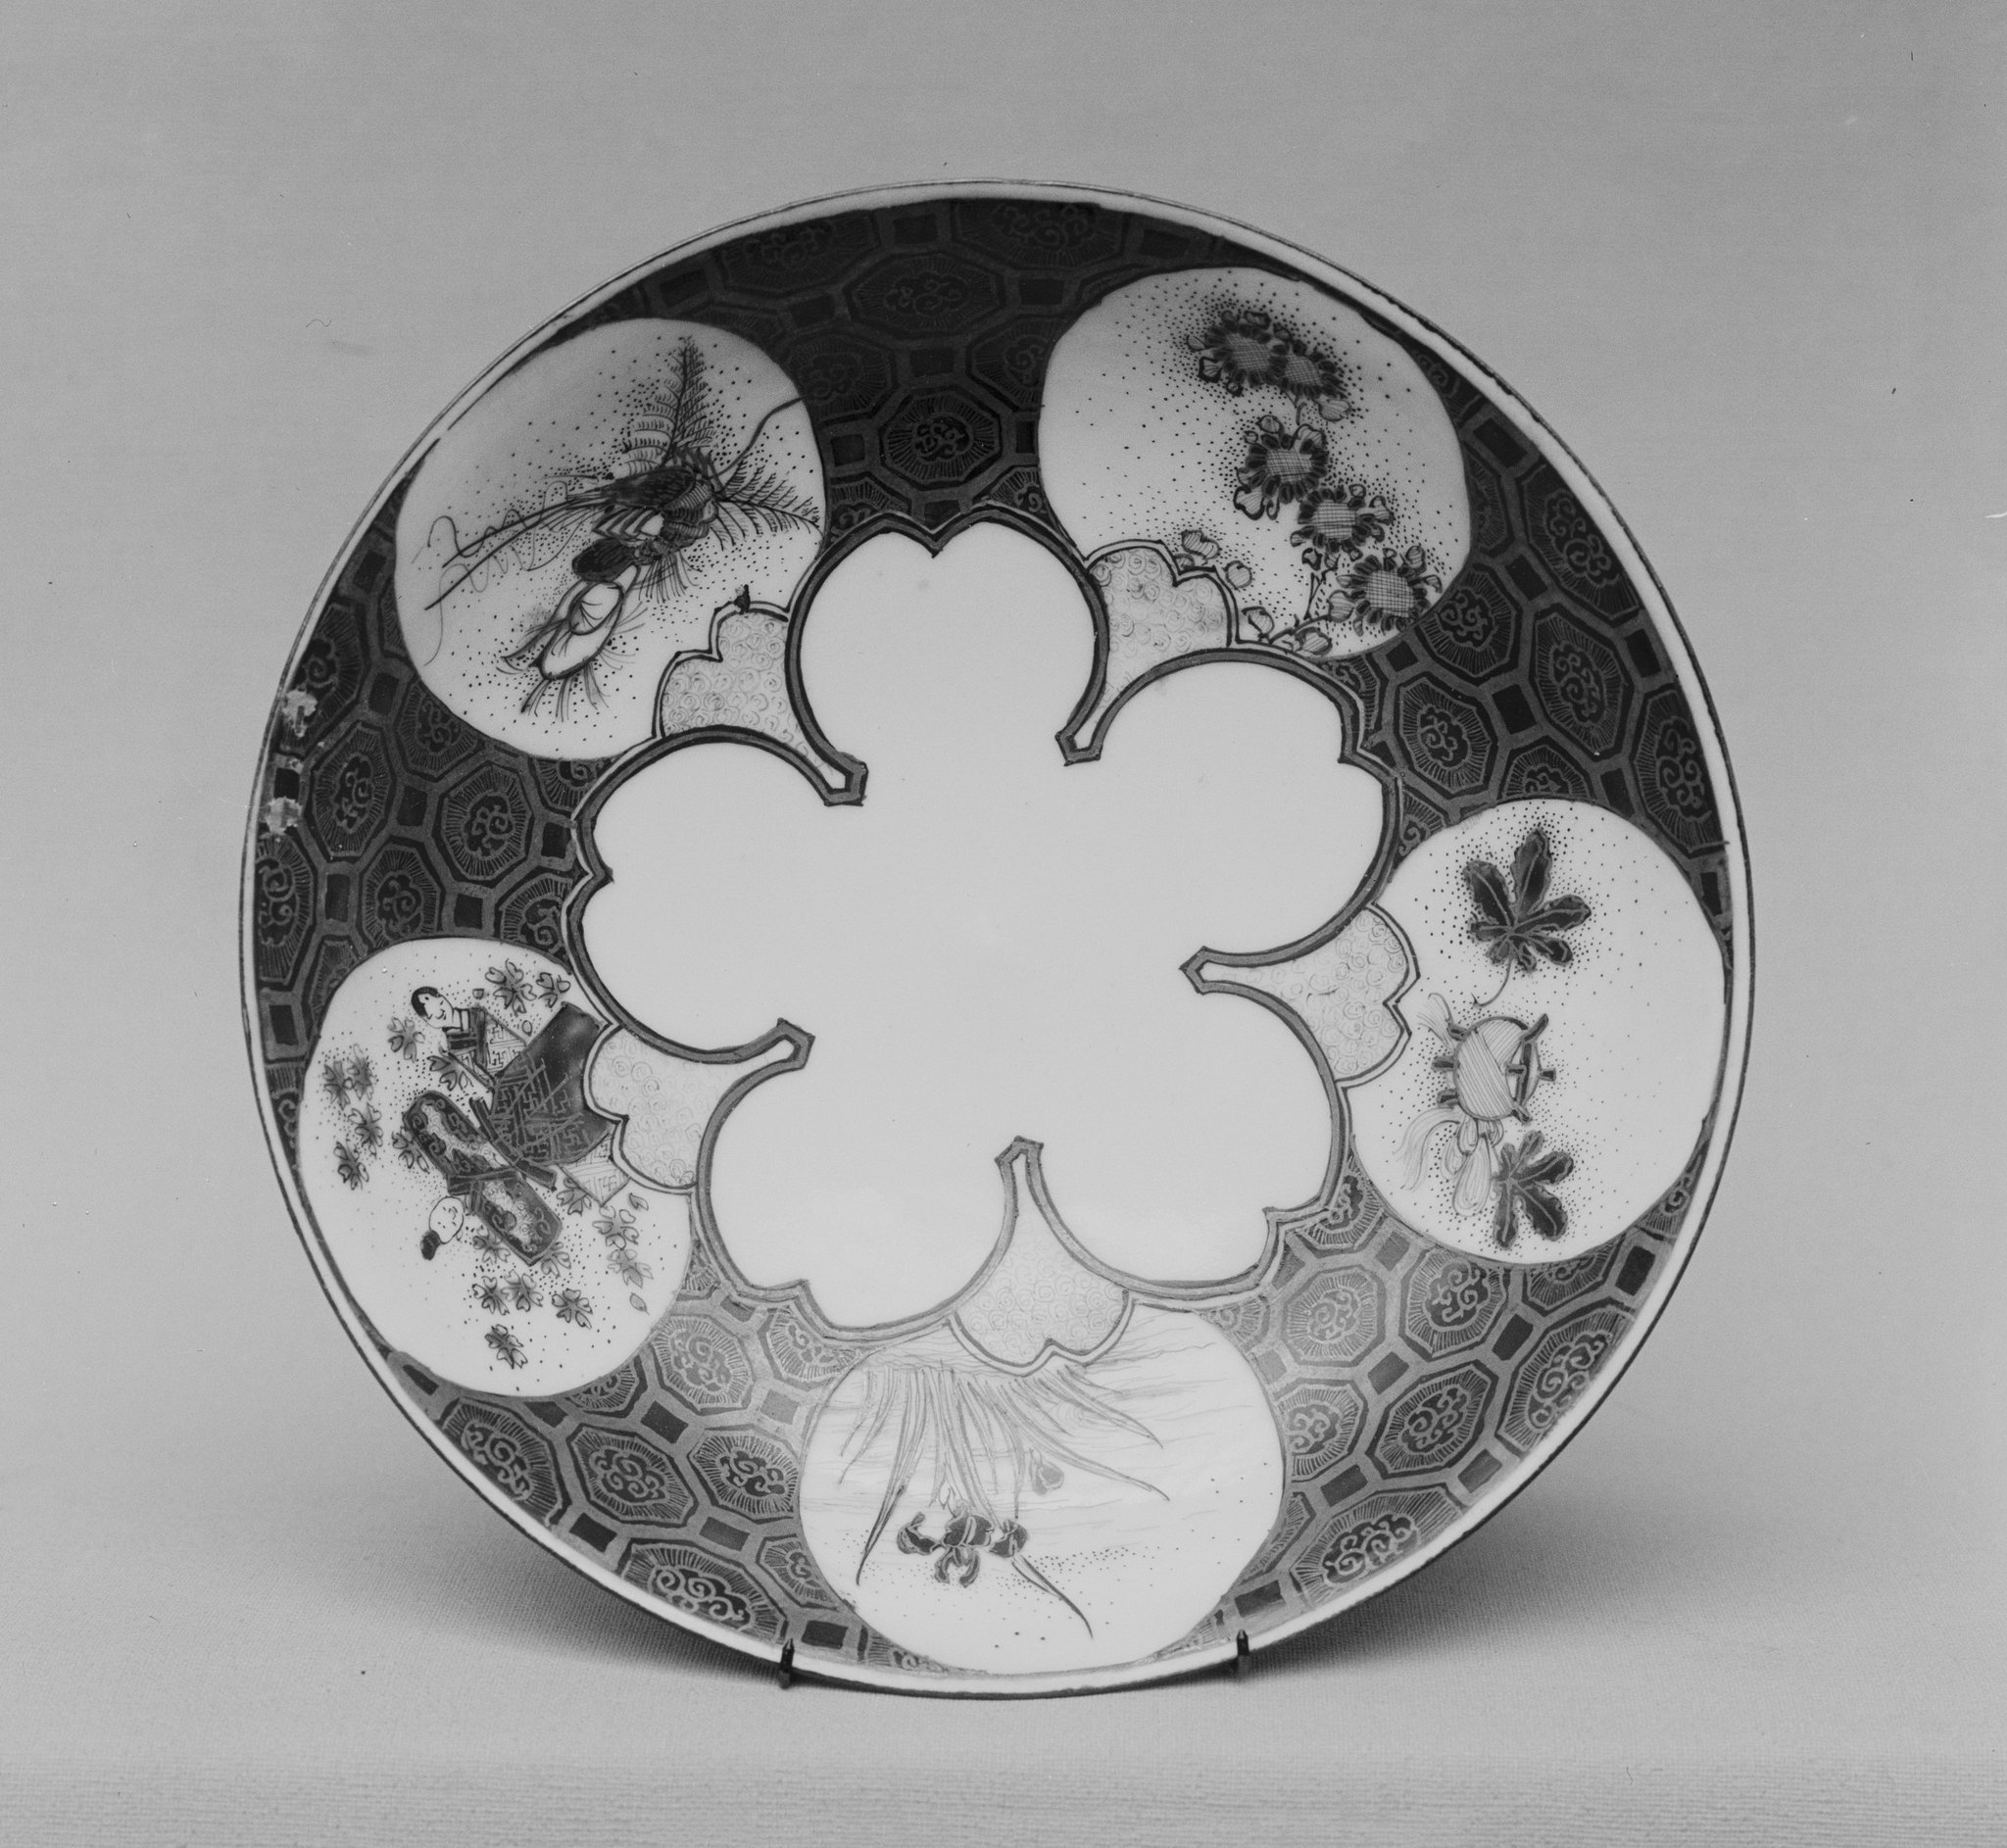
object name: saucer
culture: japanese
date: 1801-1900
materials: gold, porcelain